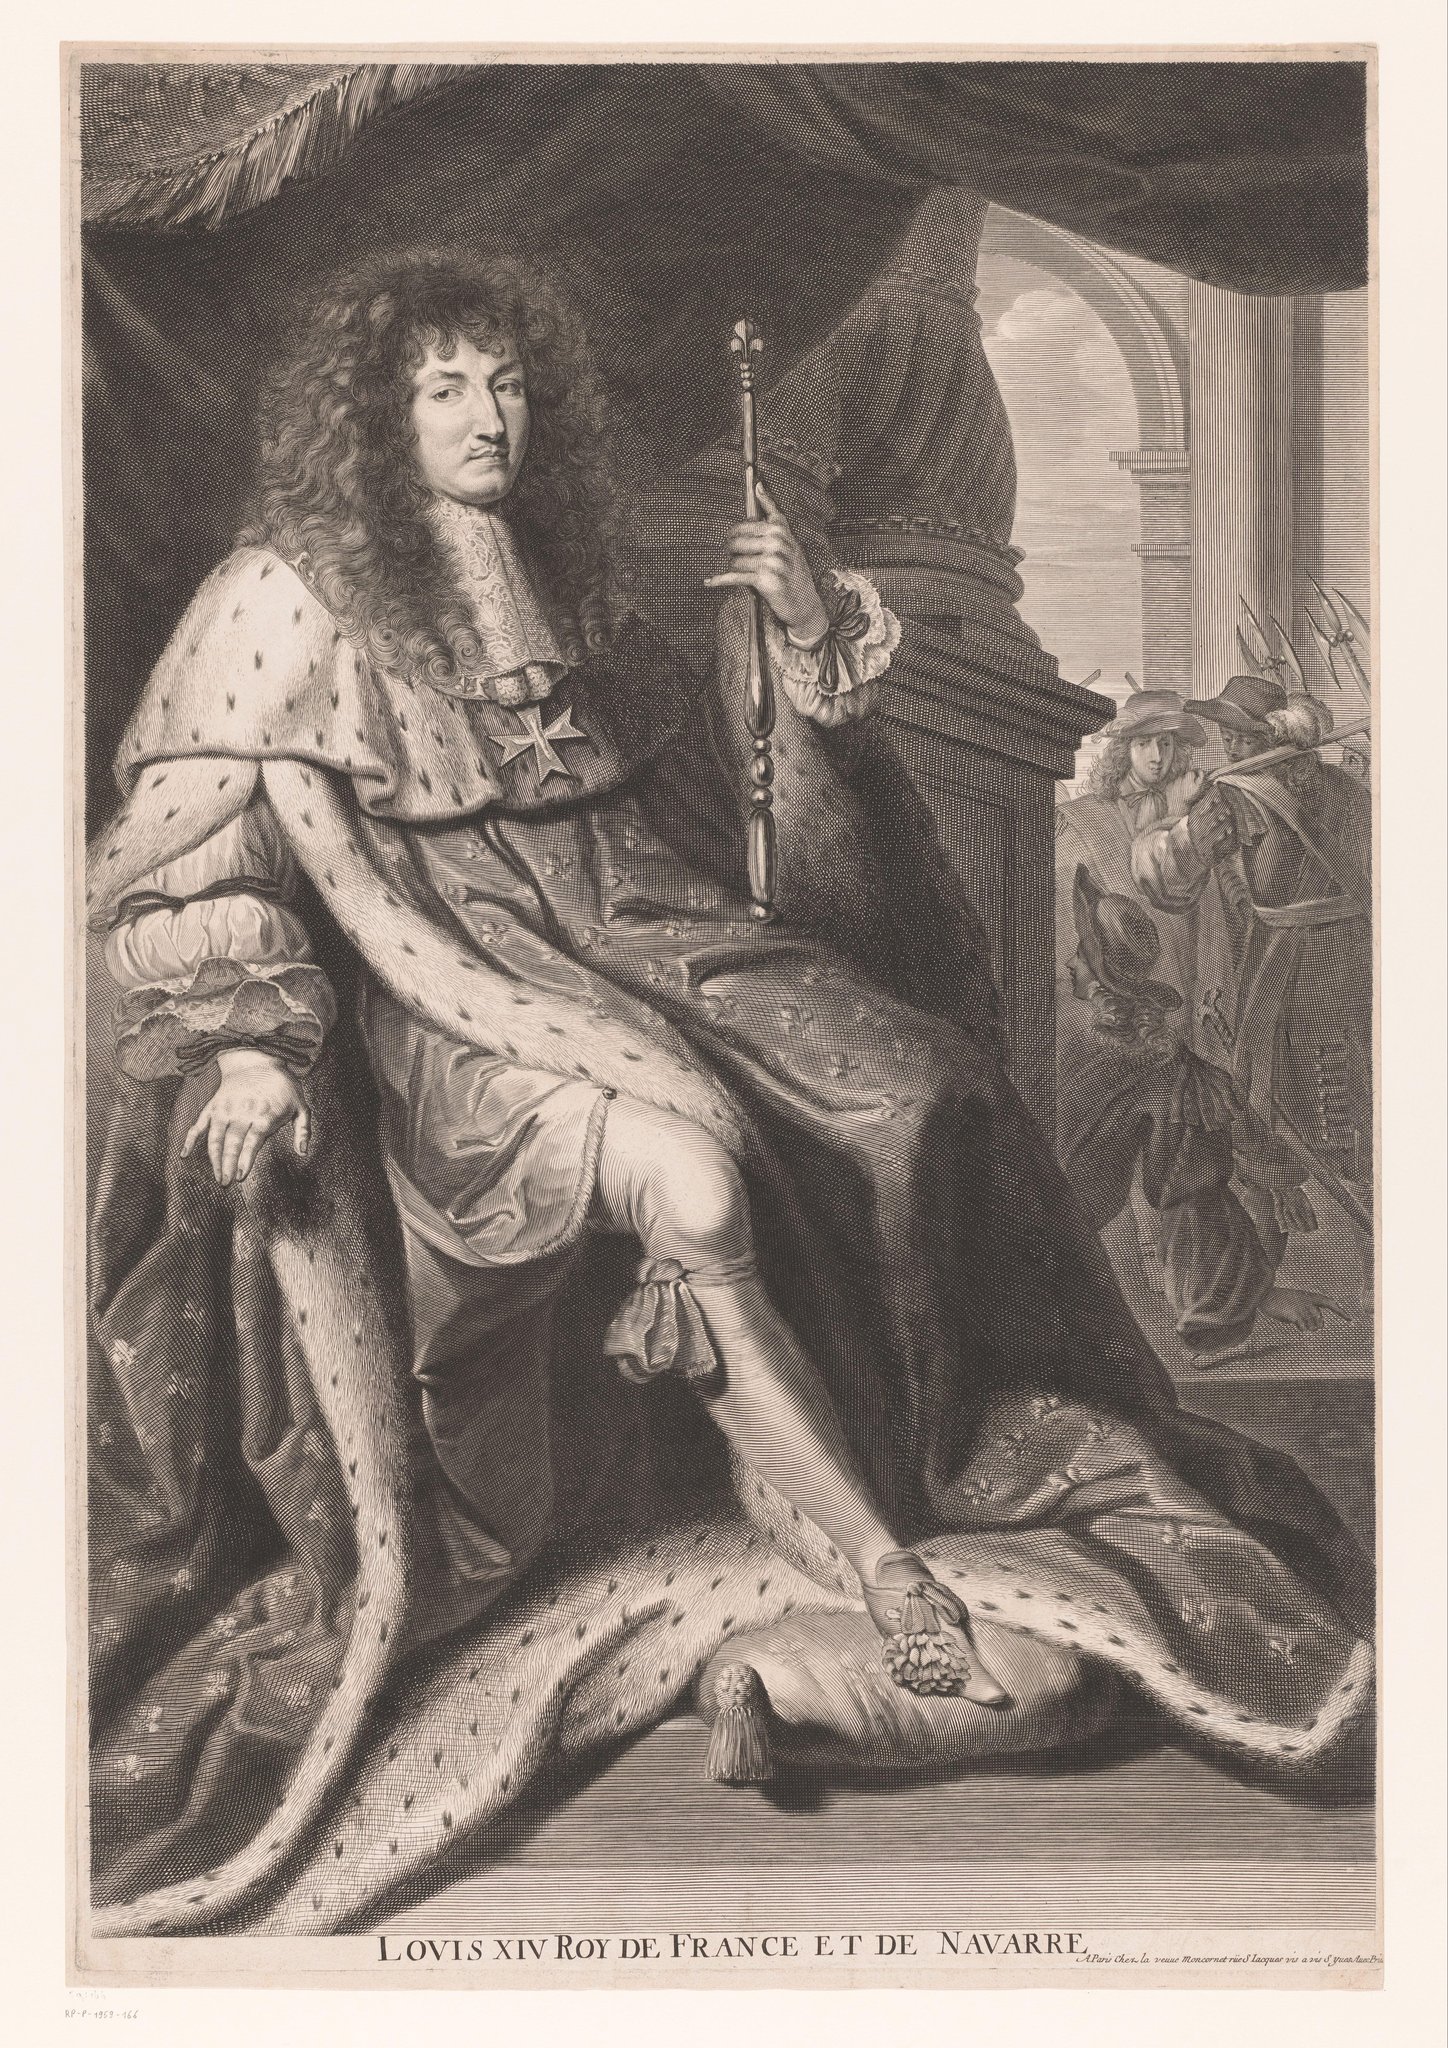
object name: print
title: Portret van Lodewijk XIV van Frankrijk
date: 1660-1683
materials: paper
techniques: engraving, etching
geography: france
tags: lodewijk xiv (koning van frankrijk), historical persons, king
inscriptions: collector's mark: Lugt 2228, collector's mark: Lugt 2760